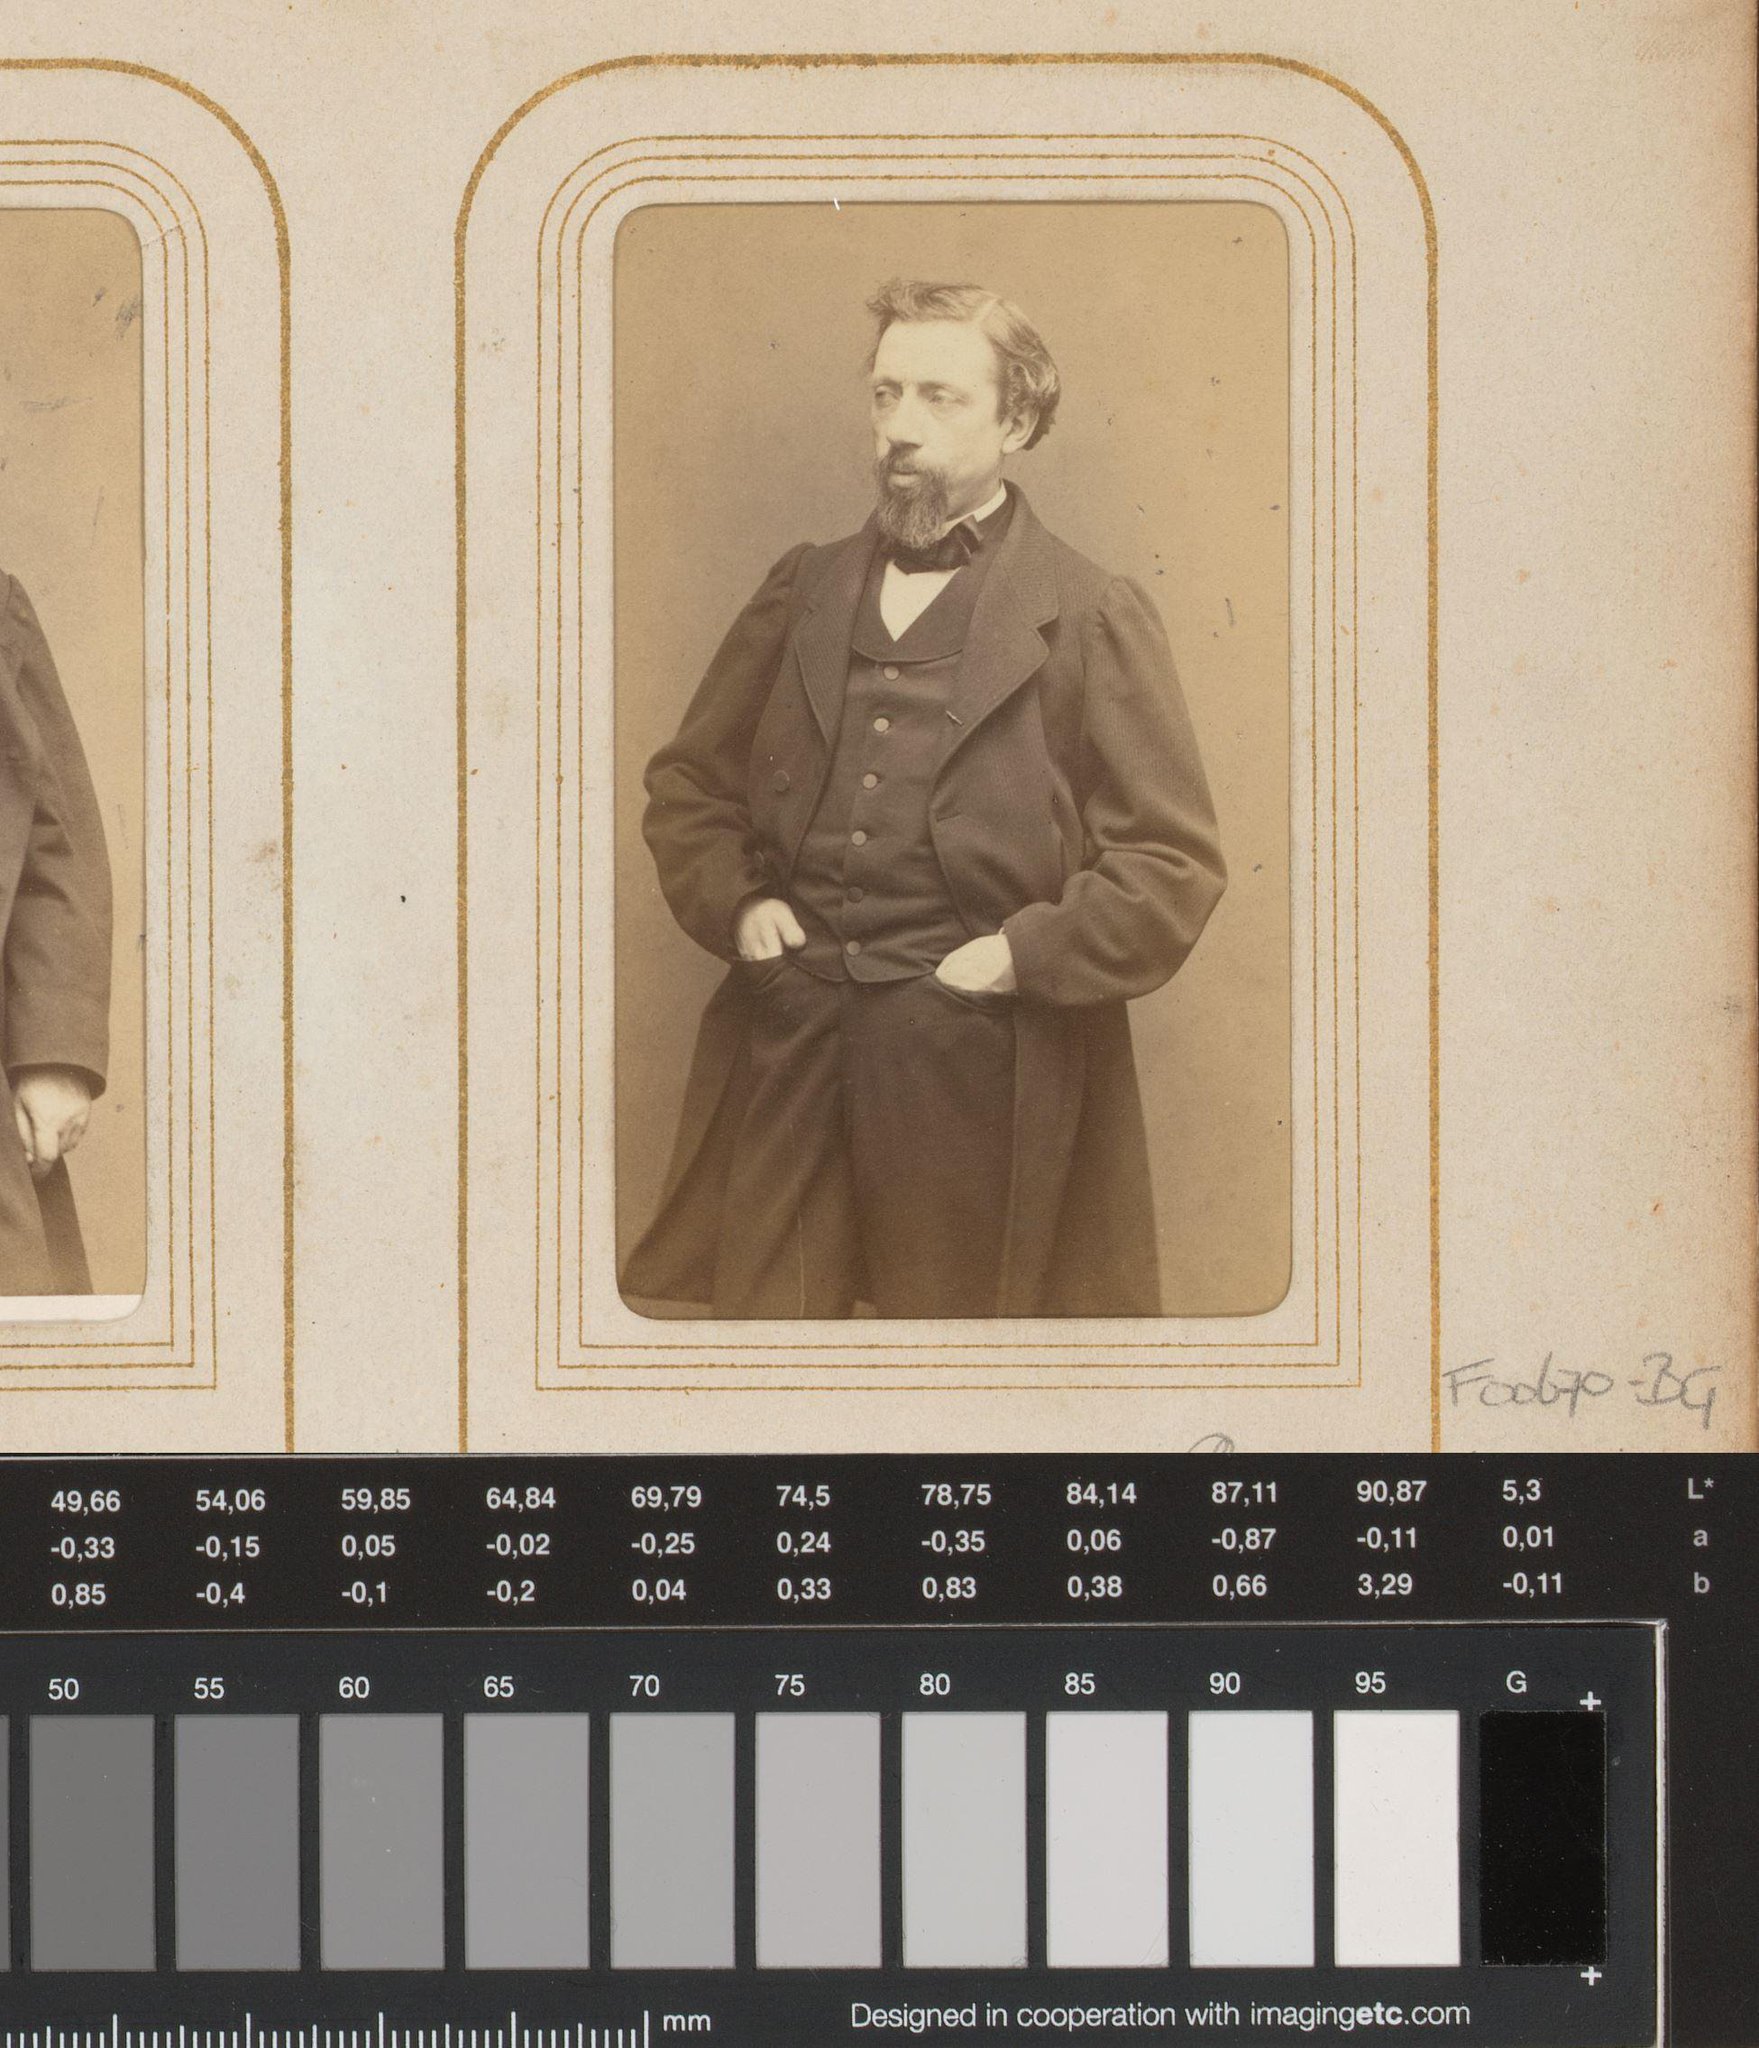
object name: album leaf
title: Portret van François-Auguste Gevaert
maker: étienne carjat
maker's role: draughtsman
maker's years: 1828-1906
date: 1861-1867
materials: cardboard, photographic support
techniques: albumen print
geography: paris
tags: historical persons, portrait of composer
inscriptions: name: ‘Gevaert’, annotation: ‘Francois Auguste Gevaert/ Belgische componist, [de opera Parijs]/ 1828 (Carjat)’, inscription: ‘Photographie/ Carjat & Cie/ 56, Rue Laffitte (...)’